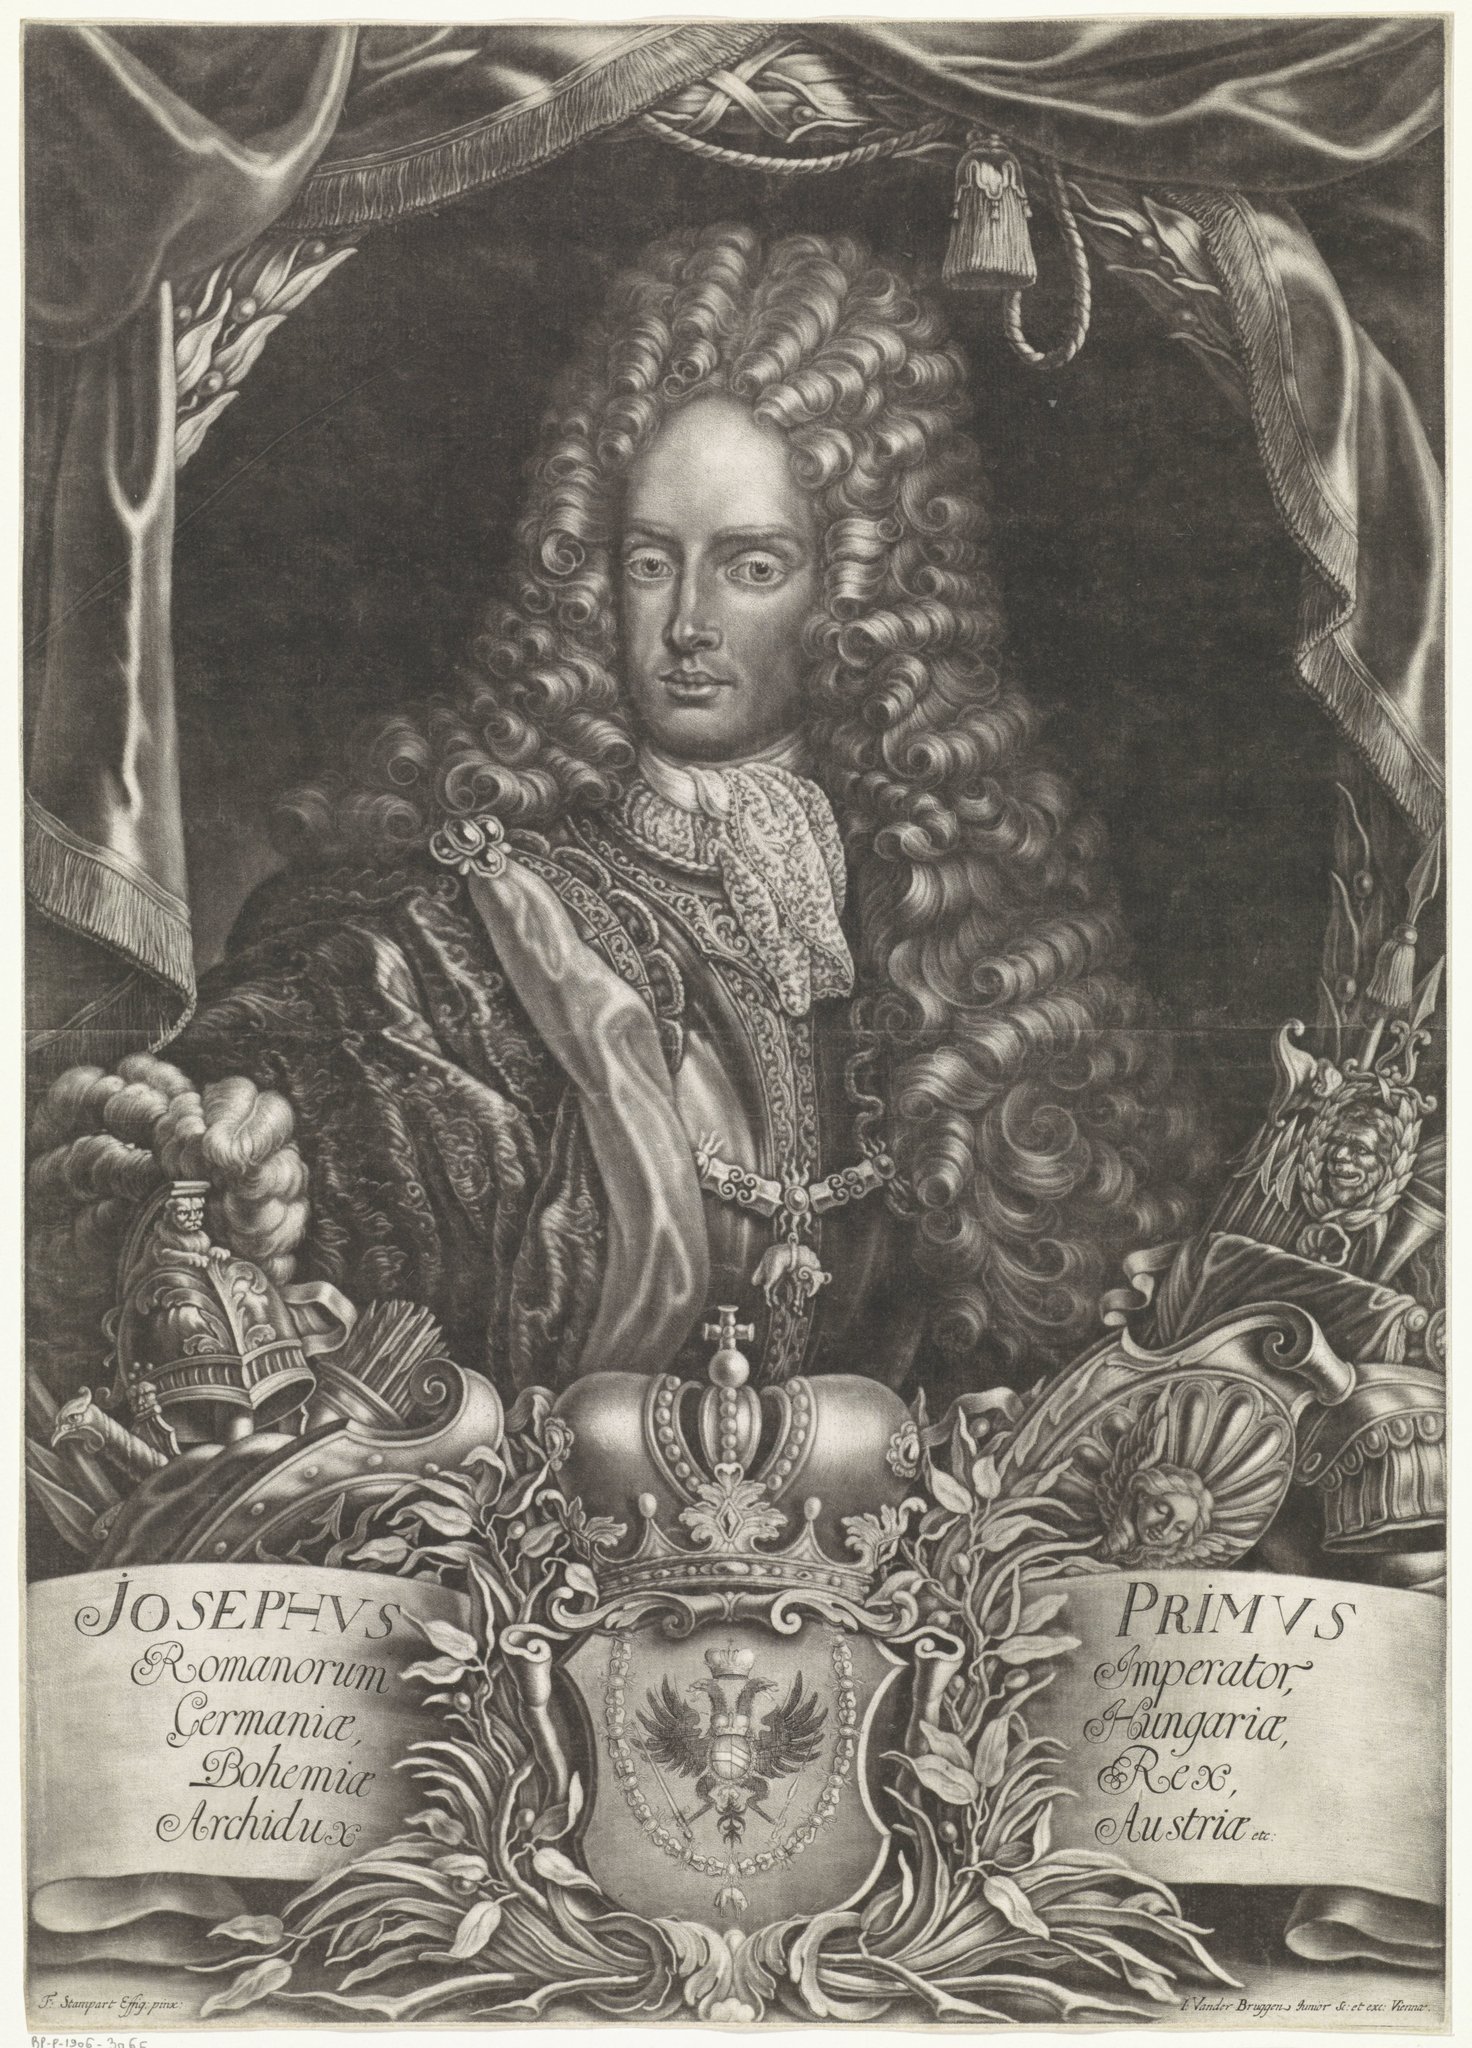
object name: print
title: Portret van keizer Jozef I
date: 1704-1740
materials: paper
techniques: engraving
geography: vienna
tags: vienna, jozef i (duits keizer), crown (symbol of sovereignty), knighthood order of the golden fleece, wig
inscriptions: collector's mark: Lugt 2228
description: Portret van Jozef I, keizer van het Heilig Roomse Rijk en koning van Hongarije. Om zijn hals een keten met het teken van de Orde van het Gulden Vlies. Het portret is gevat in een omlijsting met olijftakken, palmbladeren, diverse wapens en de keizerskroon.